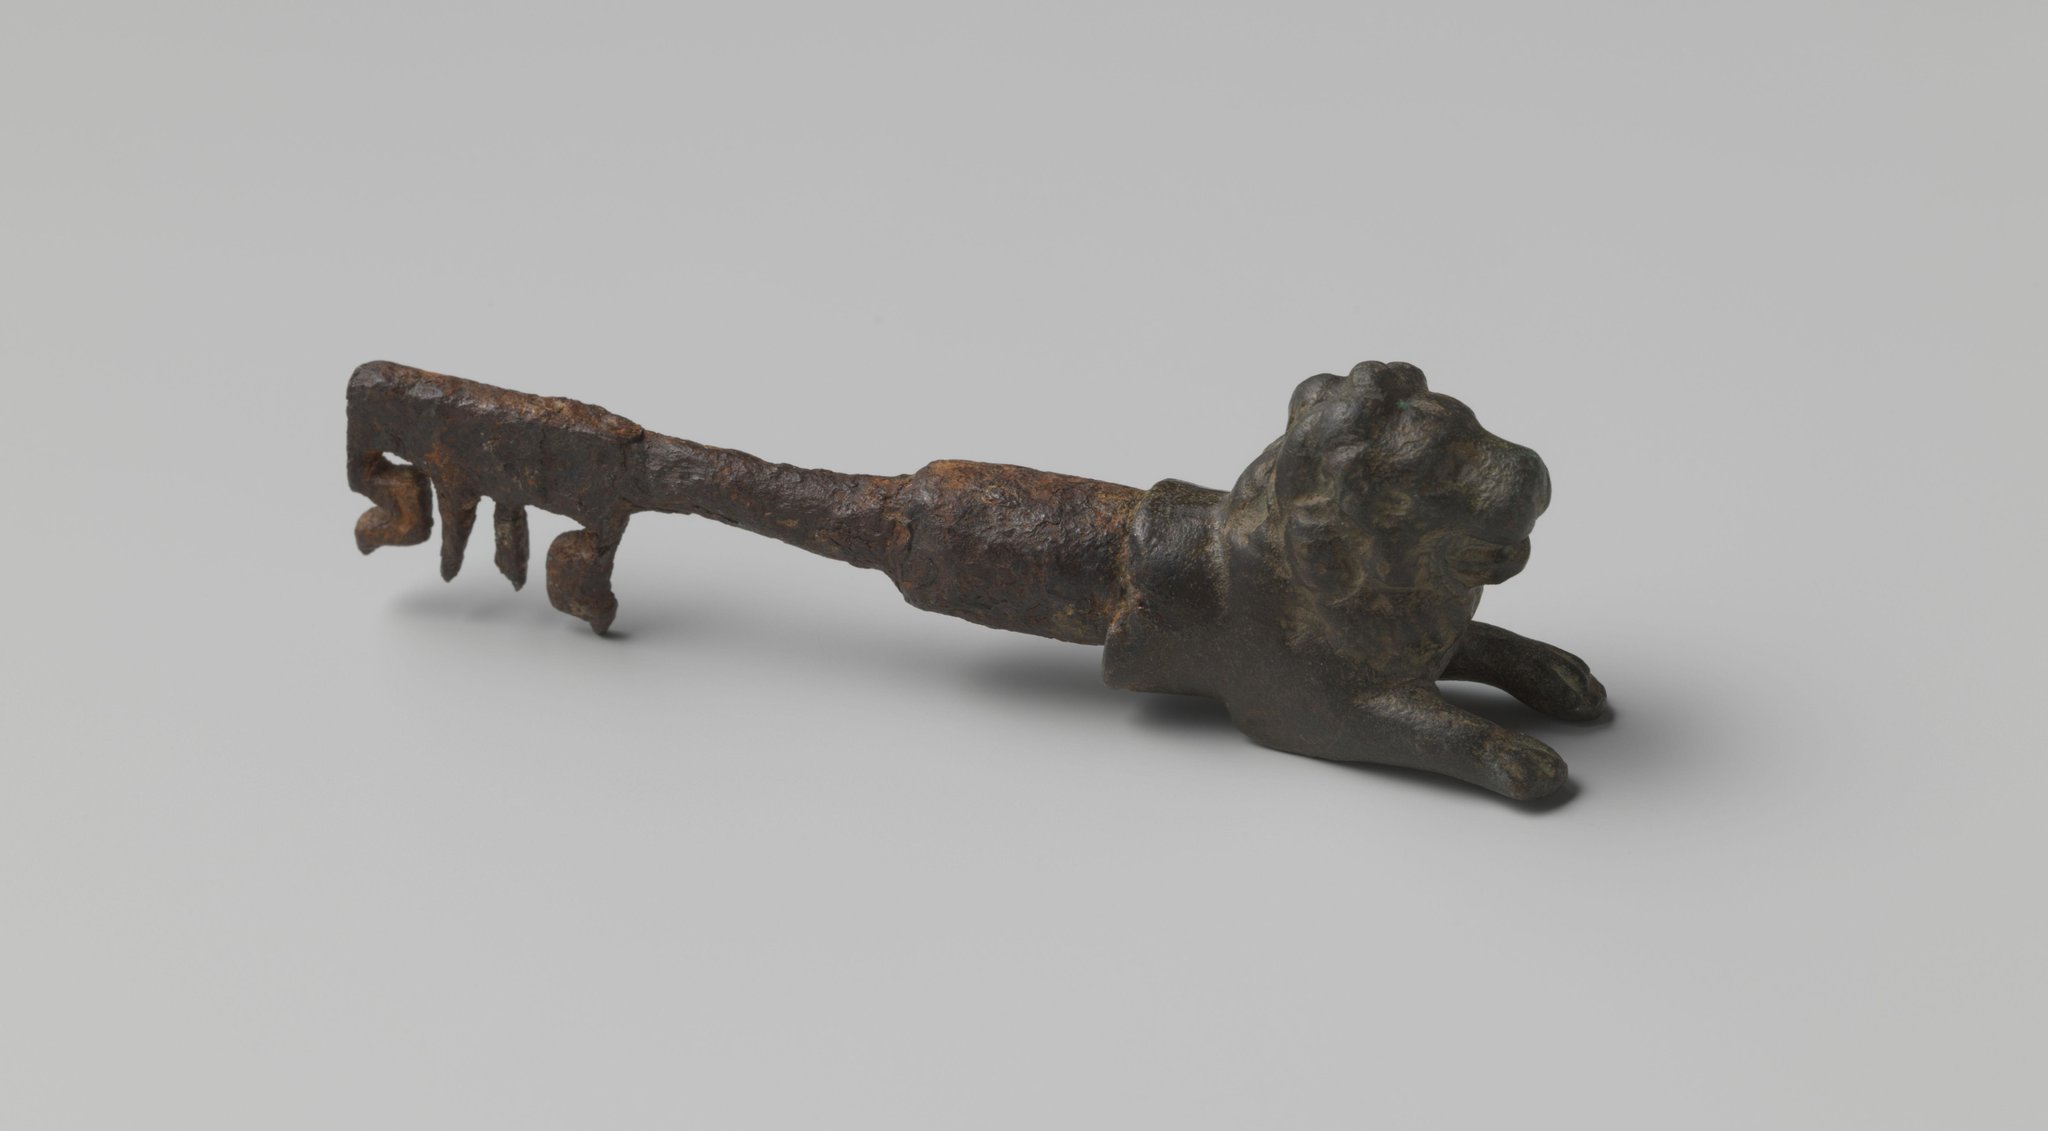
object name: key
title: Sleutel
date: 1400-1950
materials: bronze, iron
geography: rome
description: Sleutel waarvan de greep het voorgedeelte van een leeuw voorstelt. Greep van brons en steel en baard van ijzer.